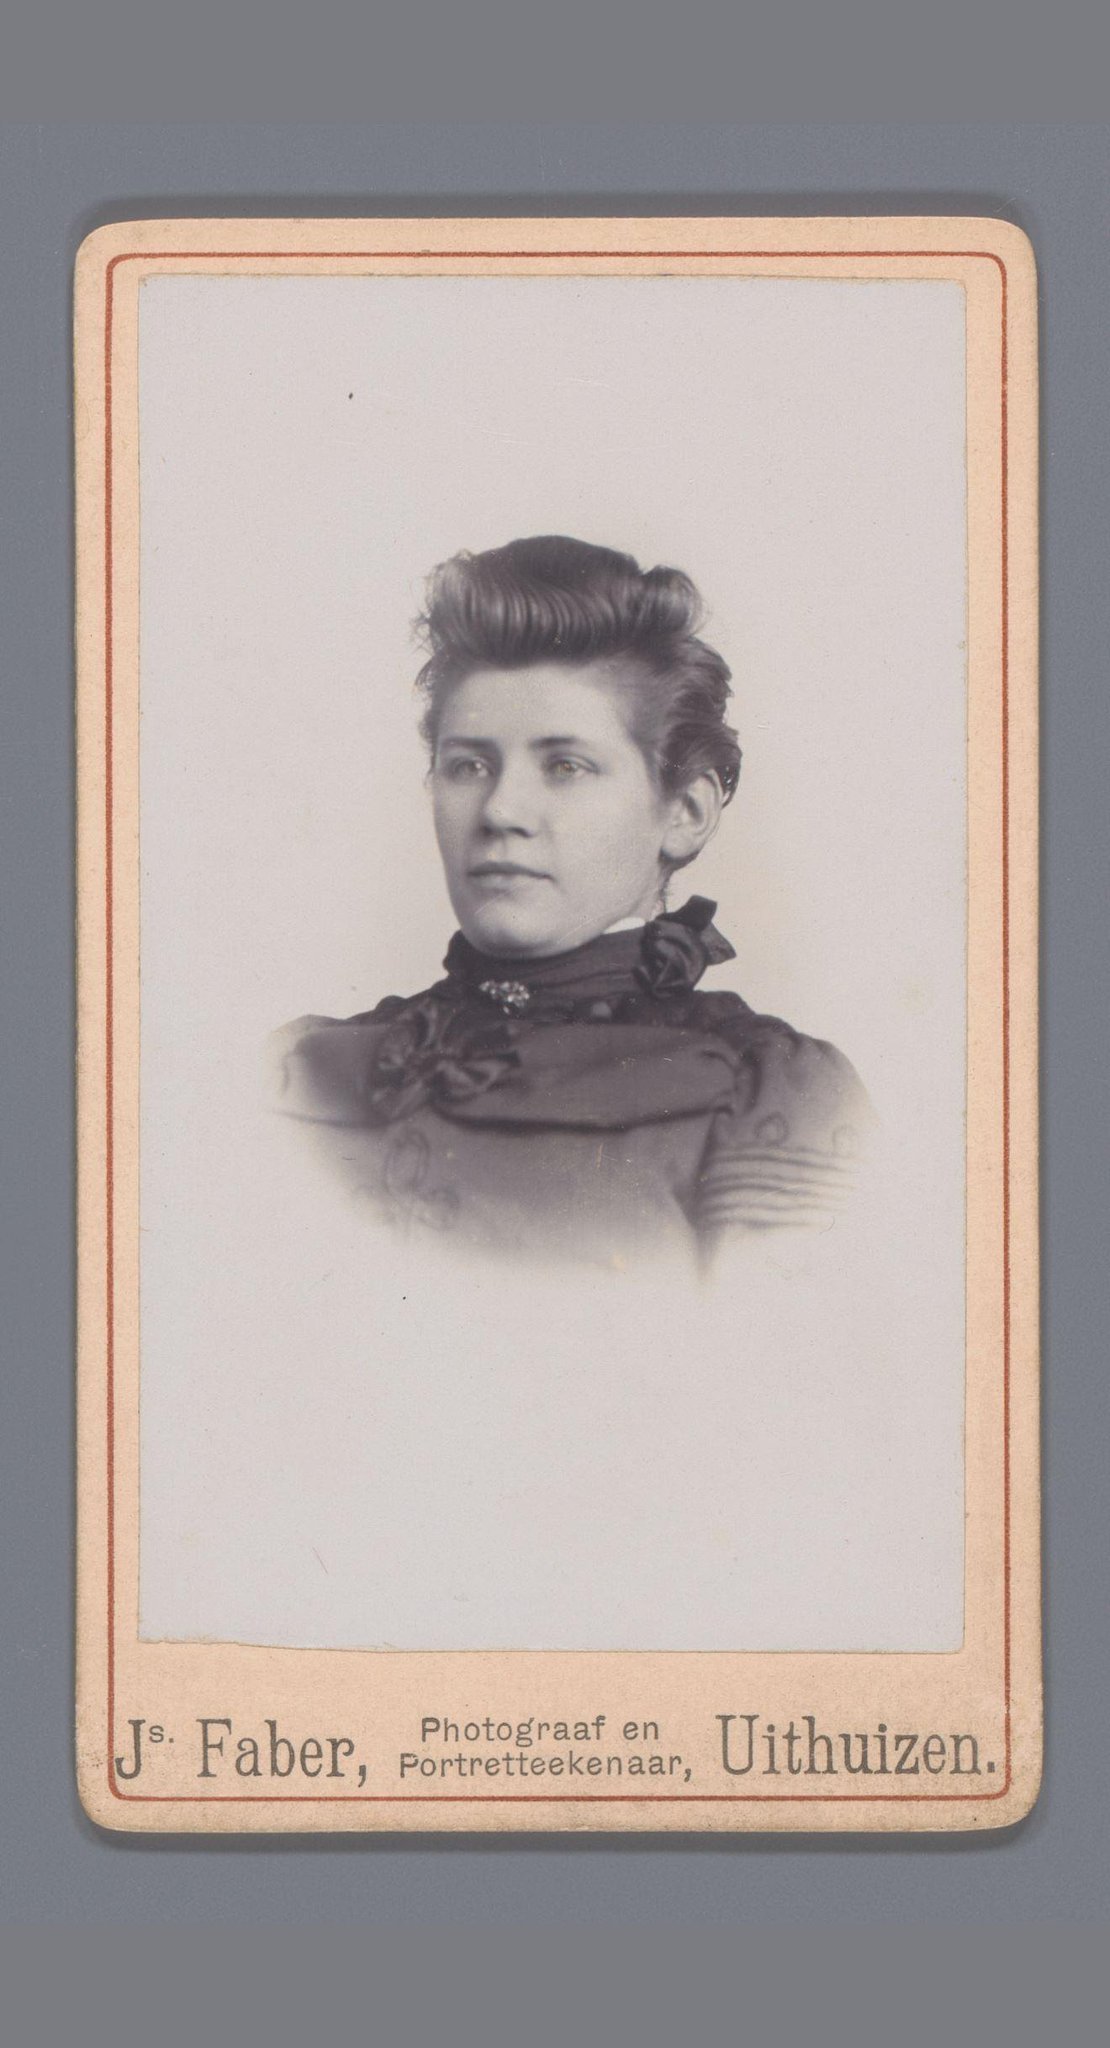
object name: photograph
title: Portret van een onbekende vrouw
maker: jannes faber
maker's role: fotograaf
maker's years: 1874-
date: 1897-1909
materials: paper, cardboard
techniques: collodion silver print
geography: uithuizen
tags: adult woman, anonymous historical person portrayed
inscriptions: inscription: ‘Js. Faber,/ Photograaf en/ Portretteekenaar,/ Uithuizen.’